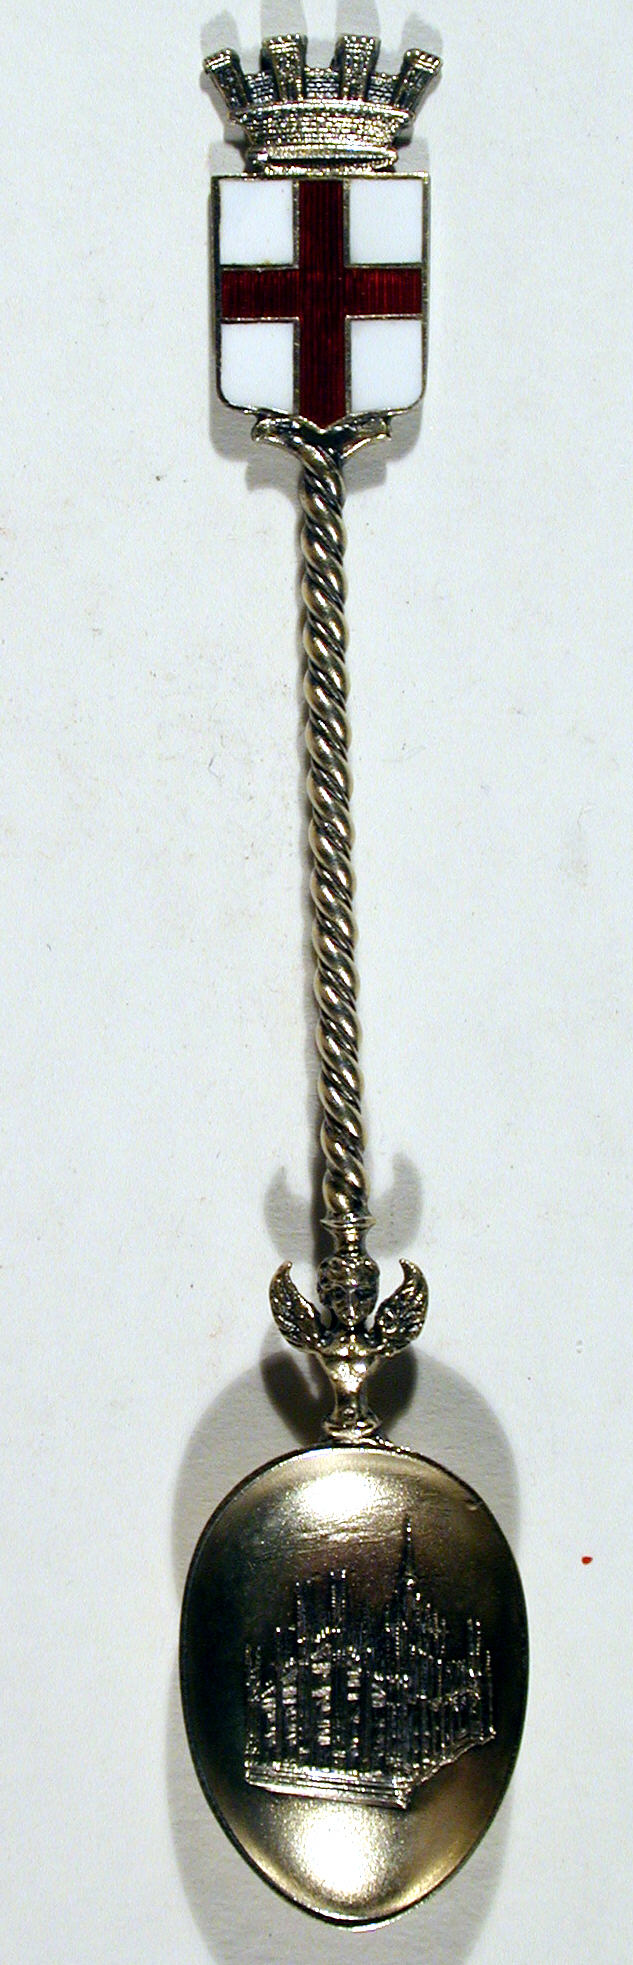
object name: souvenir spoon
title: Souvenir spoon with view of Milan Cathedral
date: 1867-1900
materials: enamel, silver gilt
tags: cathedrals,coat of arms